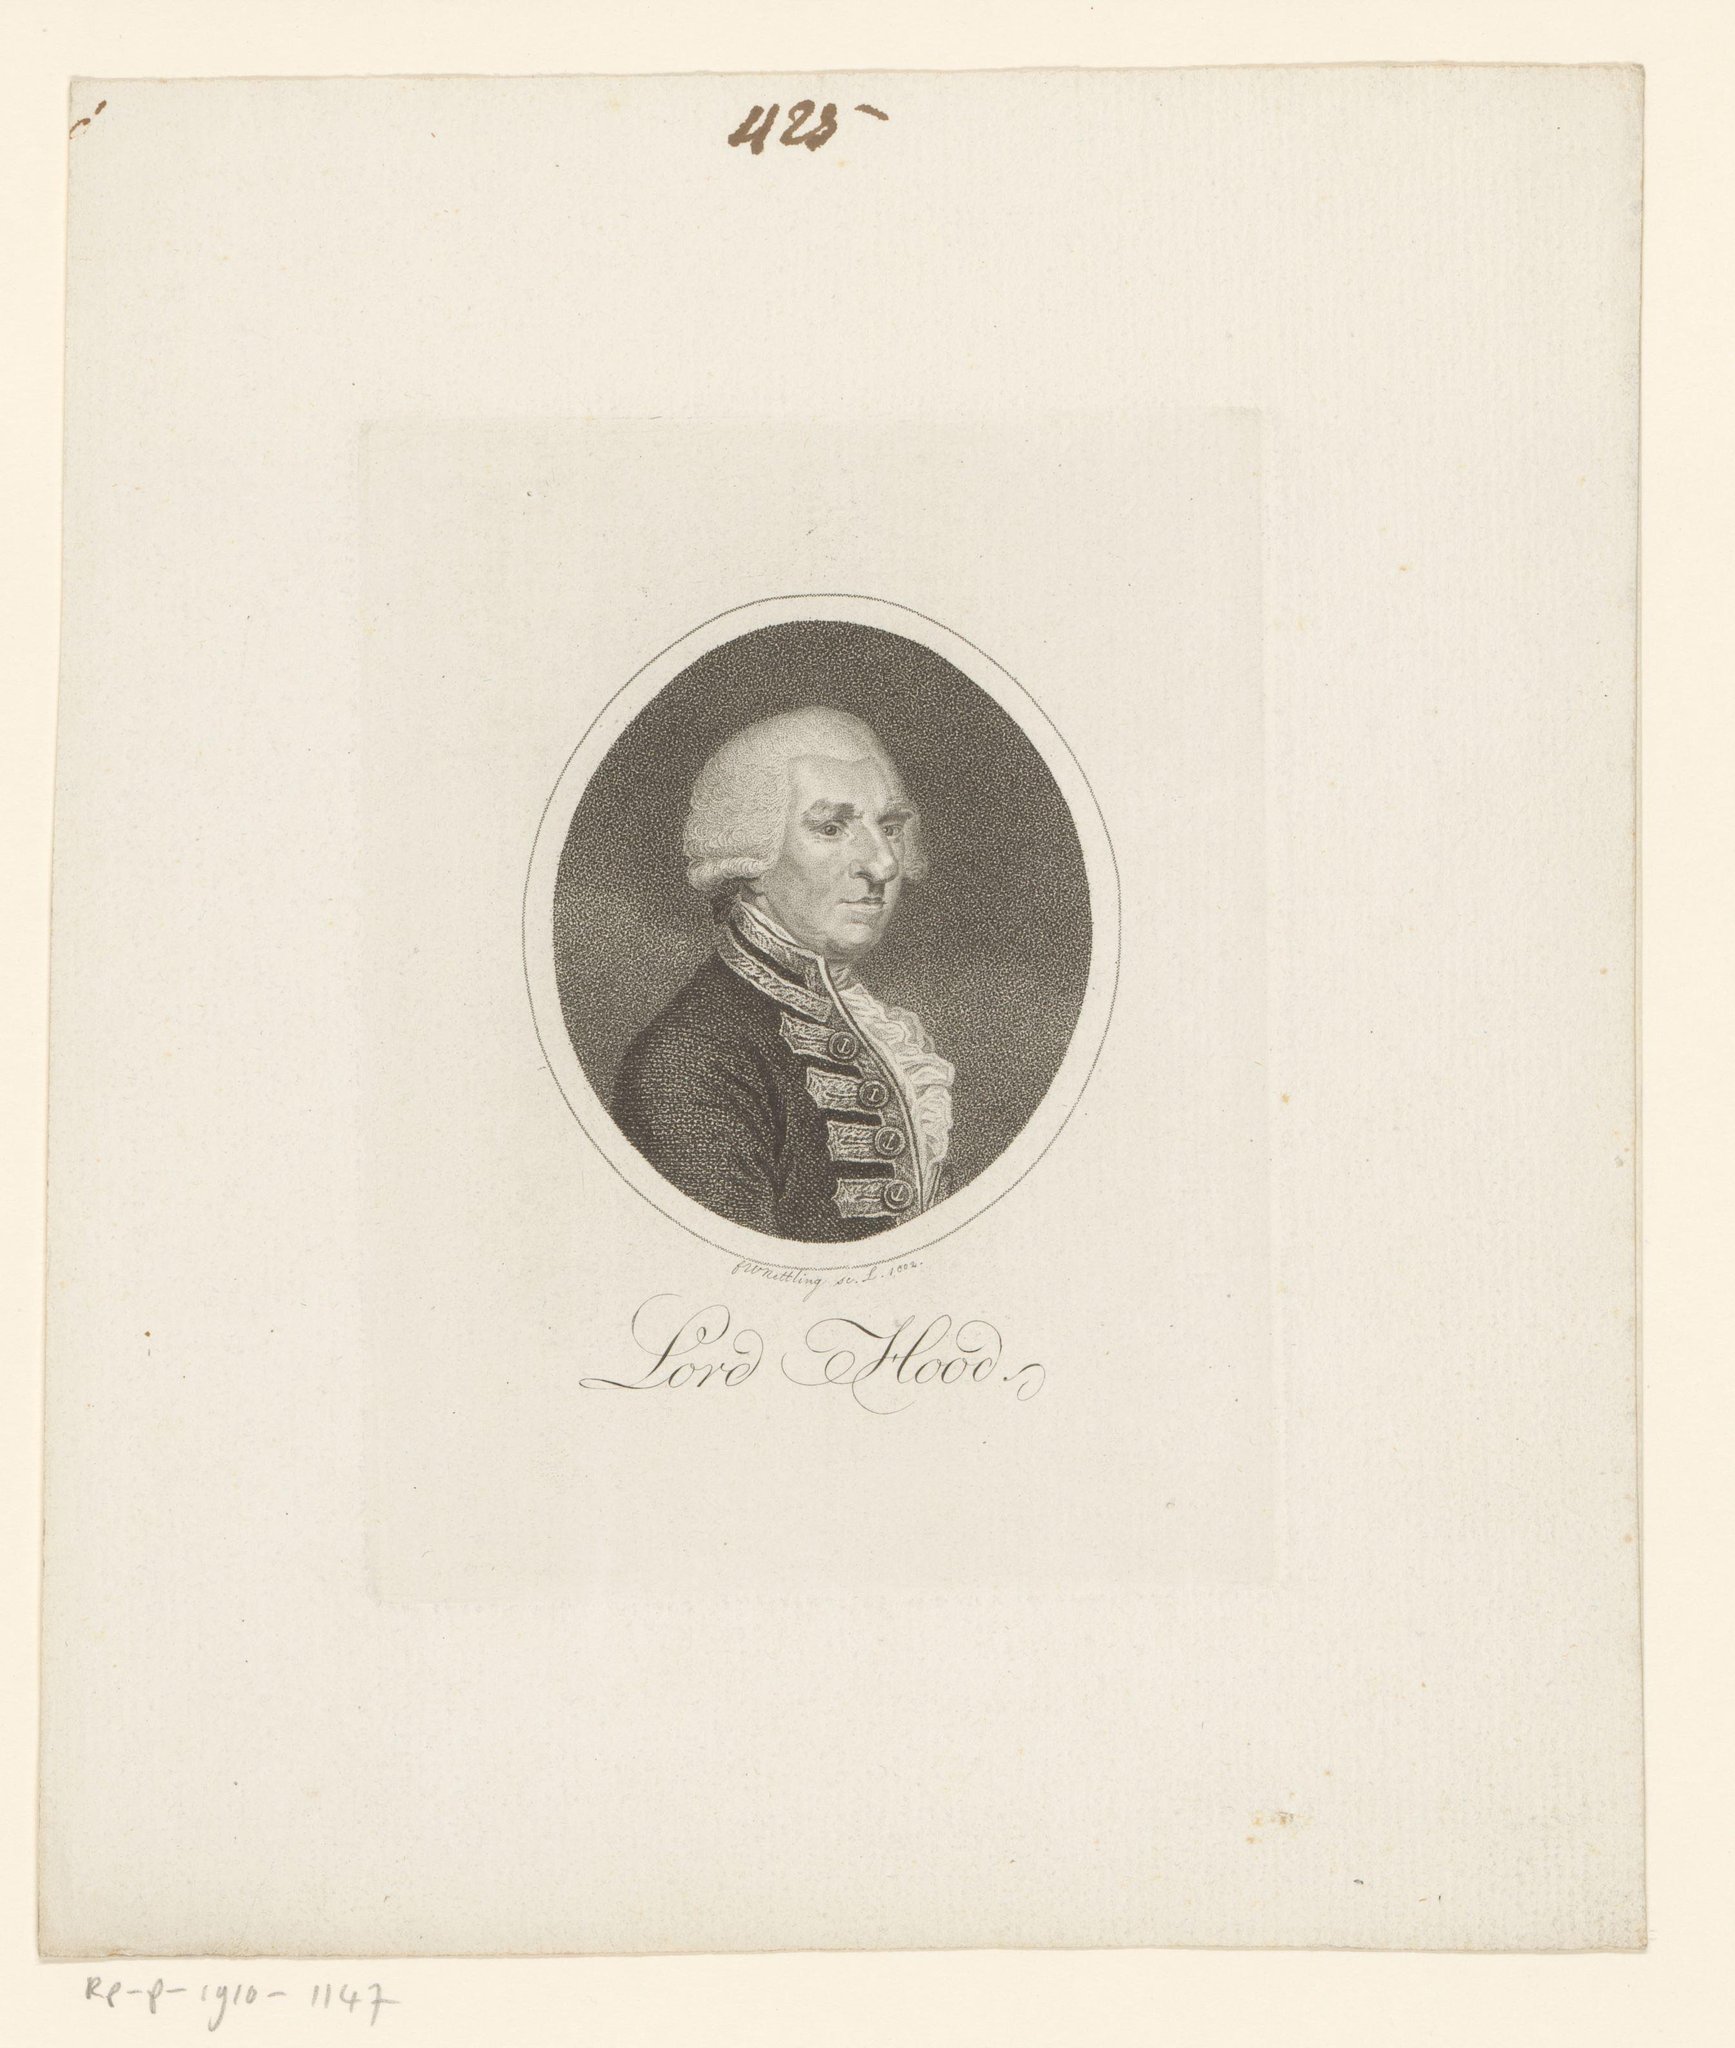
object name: print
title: Portret van Samuel Hood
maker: friedrich wilhelm nettling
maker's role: print maker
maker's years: 1793-1824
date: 1802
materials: paper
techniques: engraving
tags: historical persons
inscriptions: collector's mark: Lugt 2228